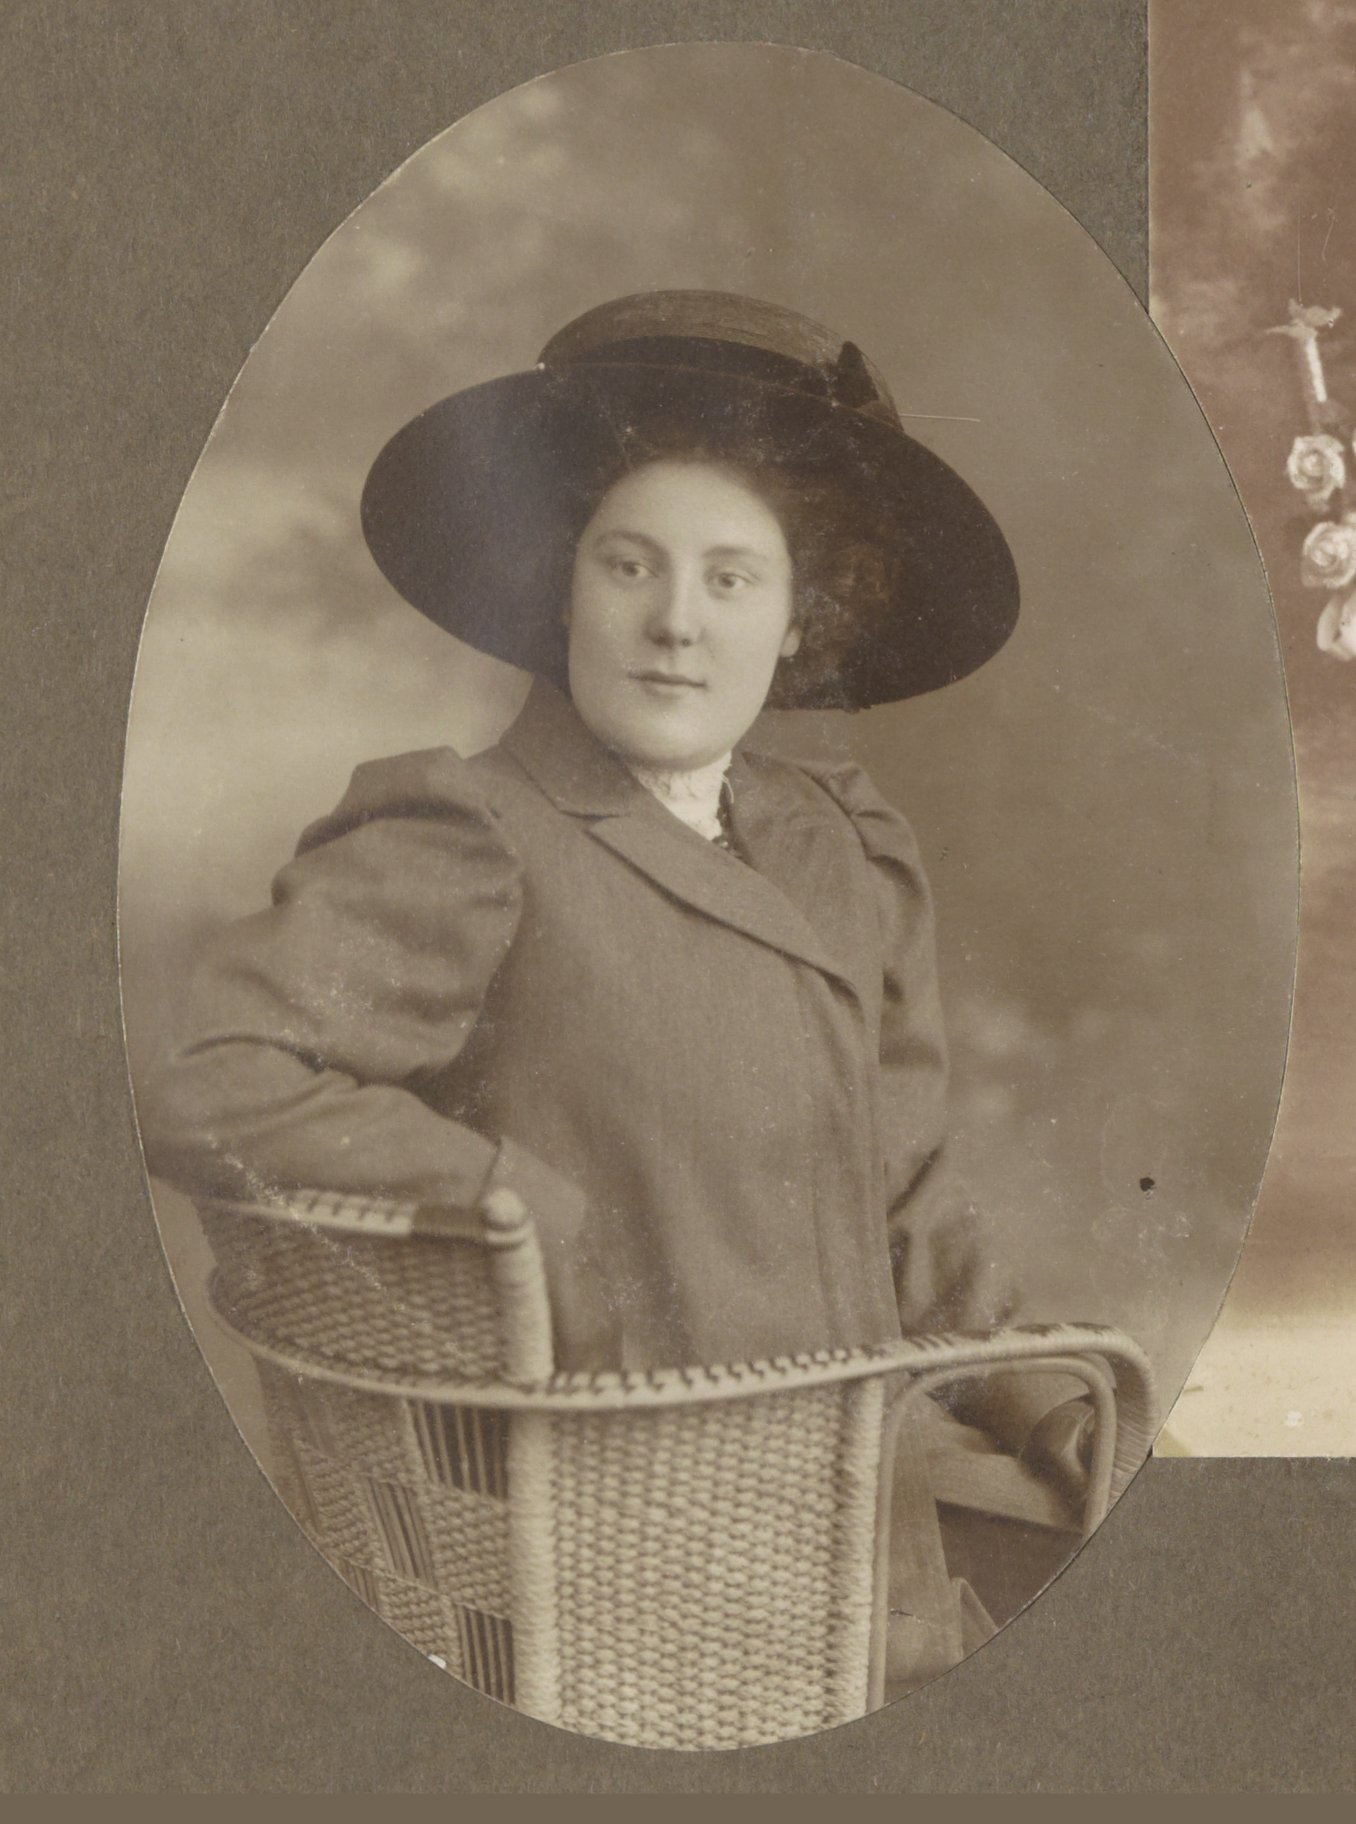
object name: photograph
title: Portret van een zittende vrouw met een lange jas en een hoed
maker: cornelis johannes lodewicus vermeulen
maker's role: fotograaf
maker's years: 1861-1936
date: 1900-1920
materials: paper, photographic support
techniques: gelatin silver print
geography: the hague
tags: adult woman, studio requisites ~ photographer, head-gear: hat, coat, cape, the hague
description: Onderdeel van Fotoalbum met opnames van het gezin en het huis van fotograaf C.J.L. Vermeulen in Den Haag.